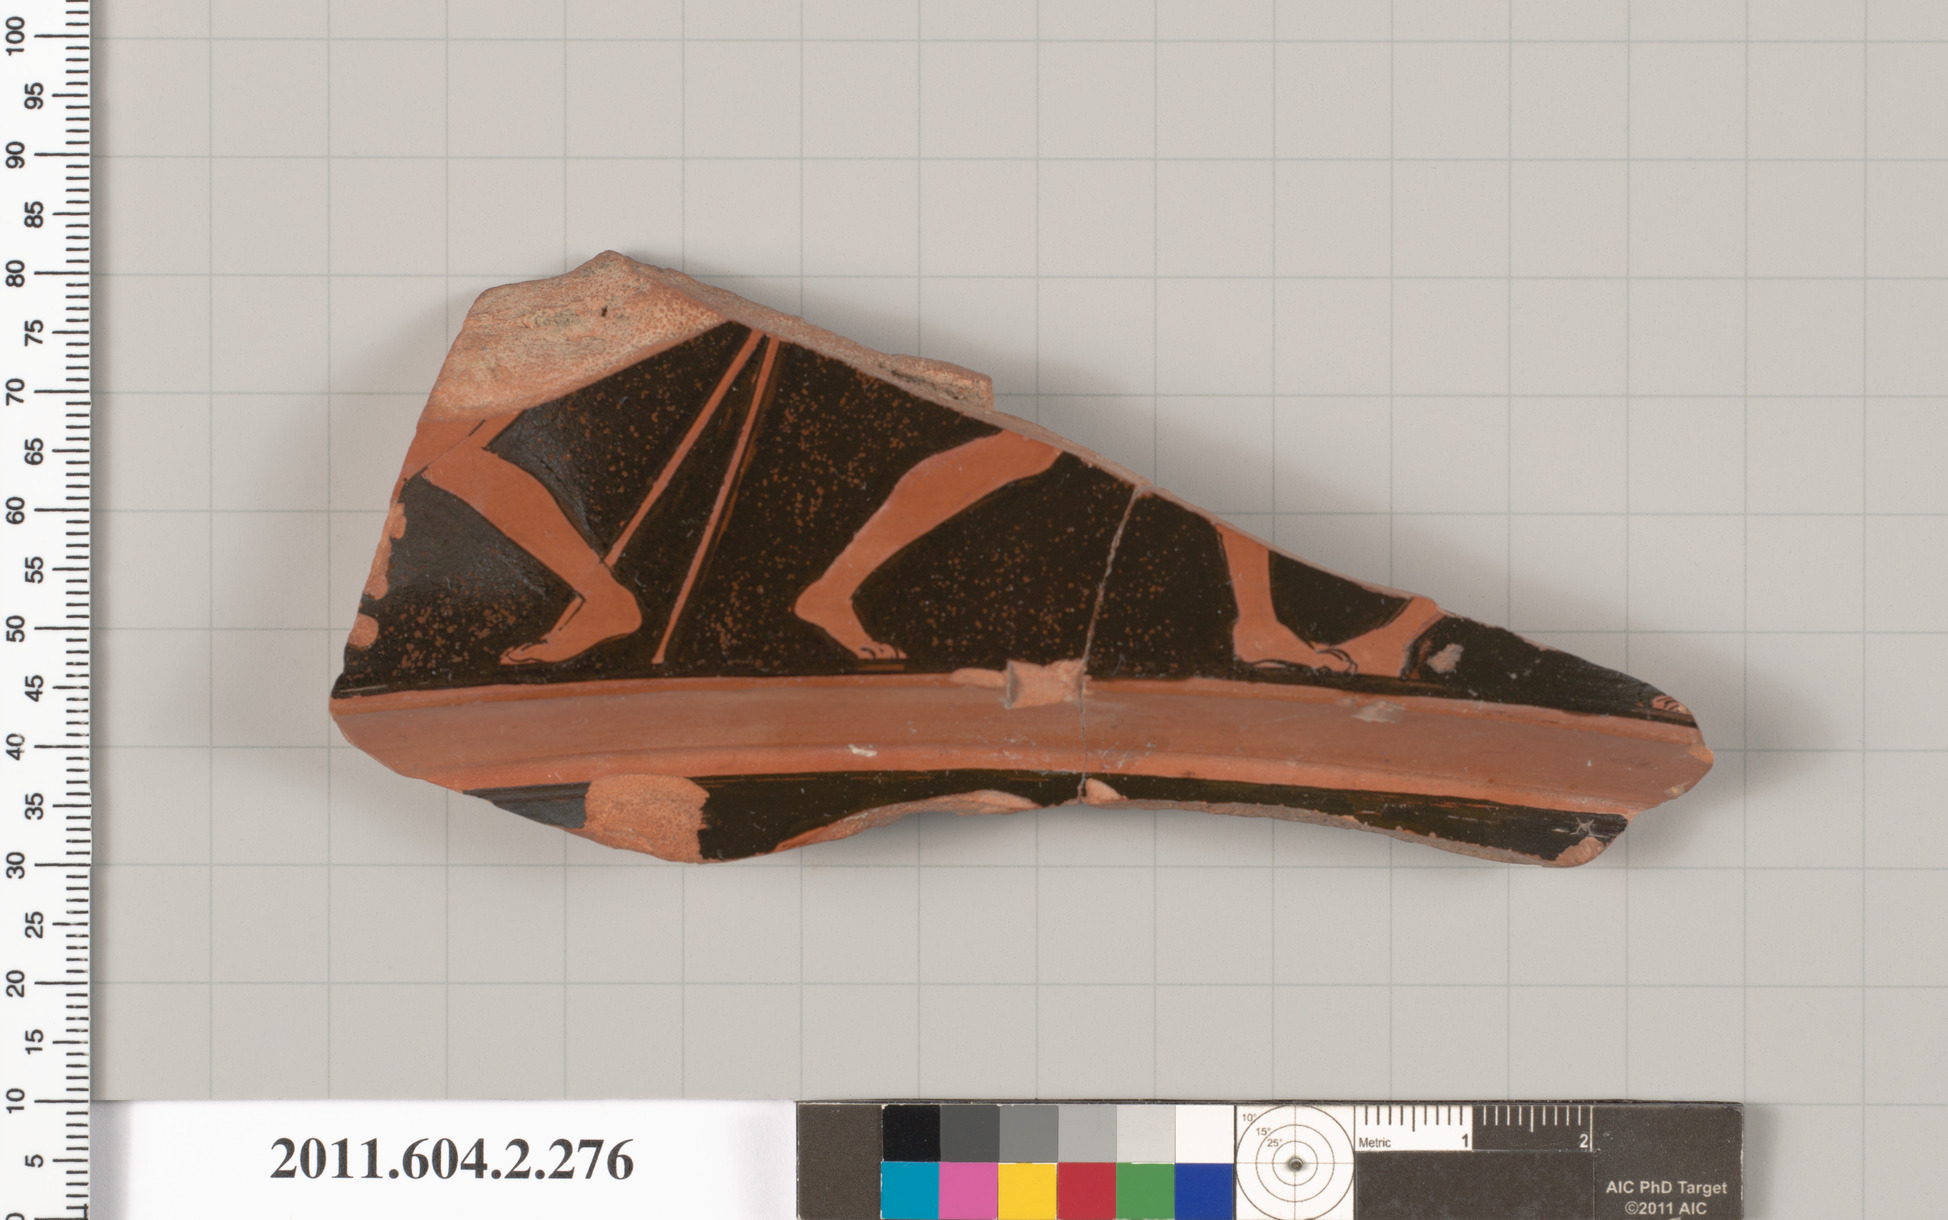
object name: volute krater fragment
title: Terracotta fragment of a volute-krater (bowl for mixing wine and water)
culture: greek, attic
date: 490-480 BCE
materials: terracotta